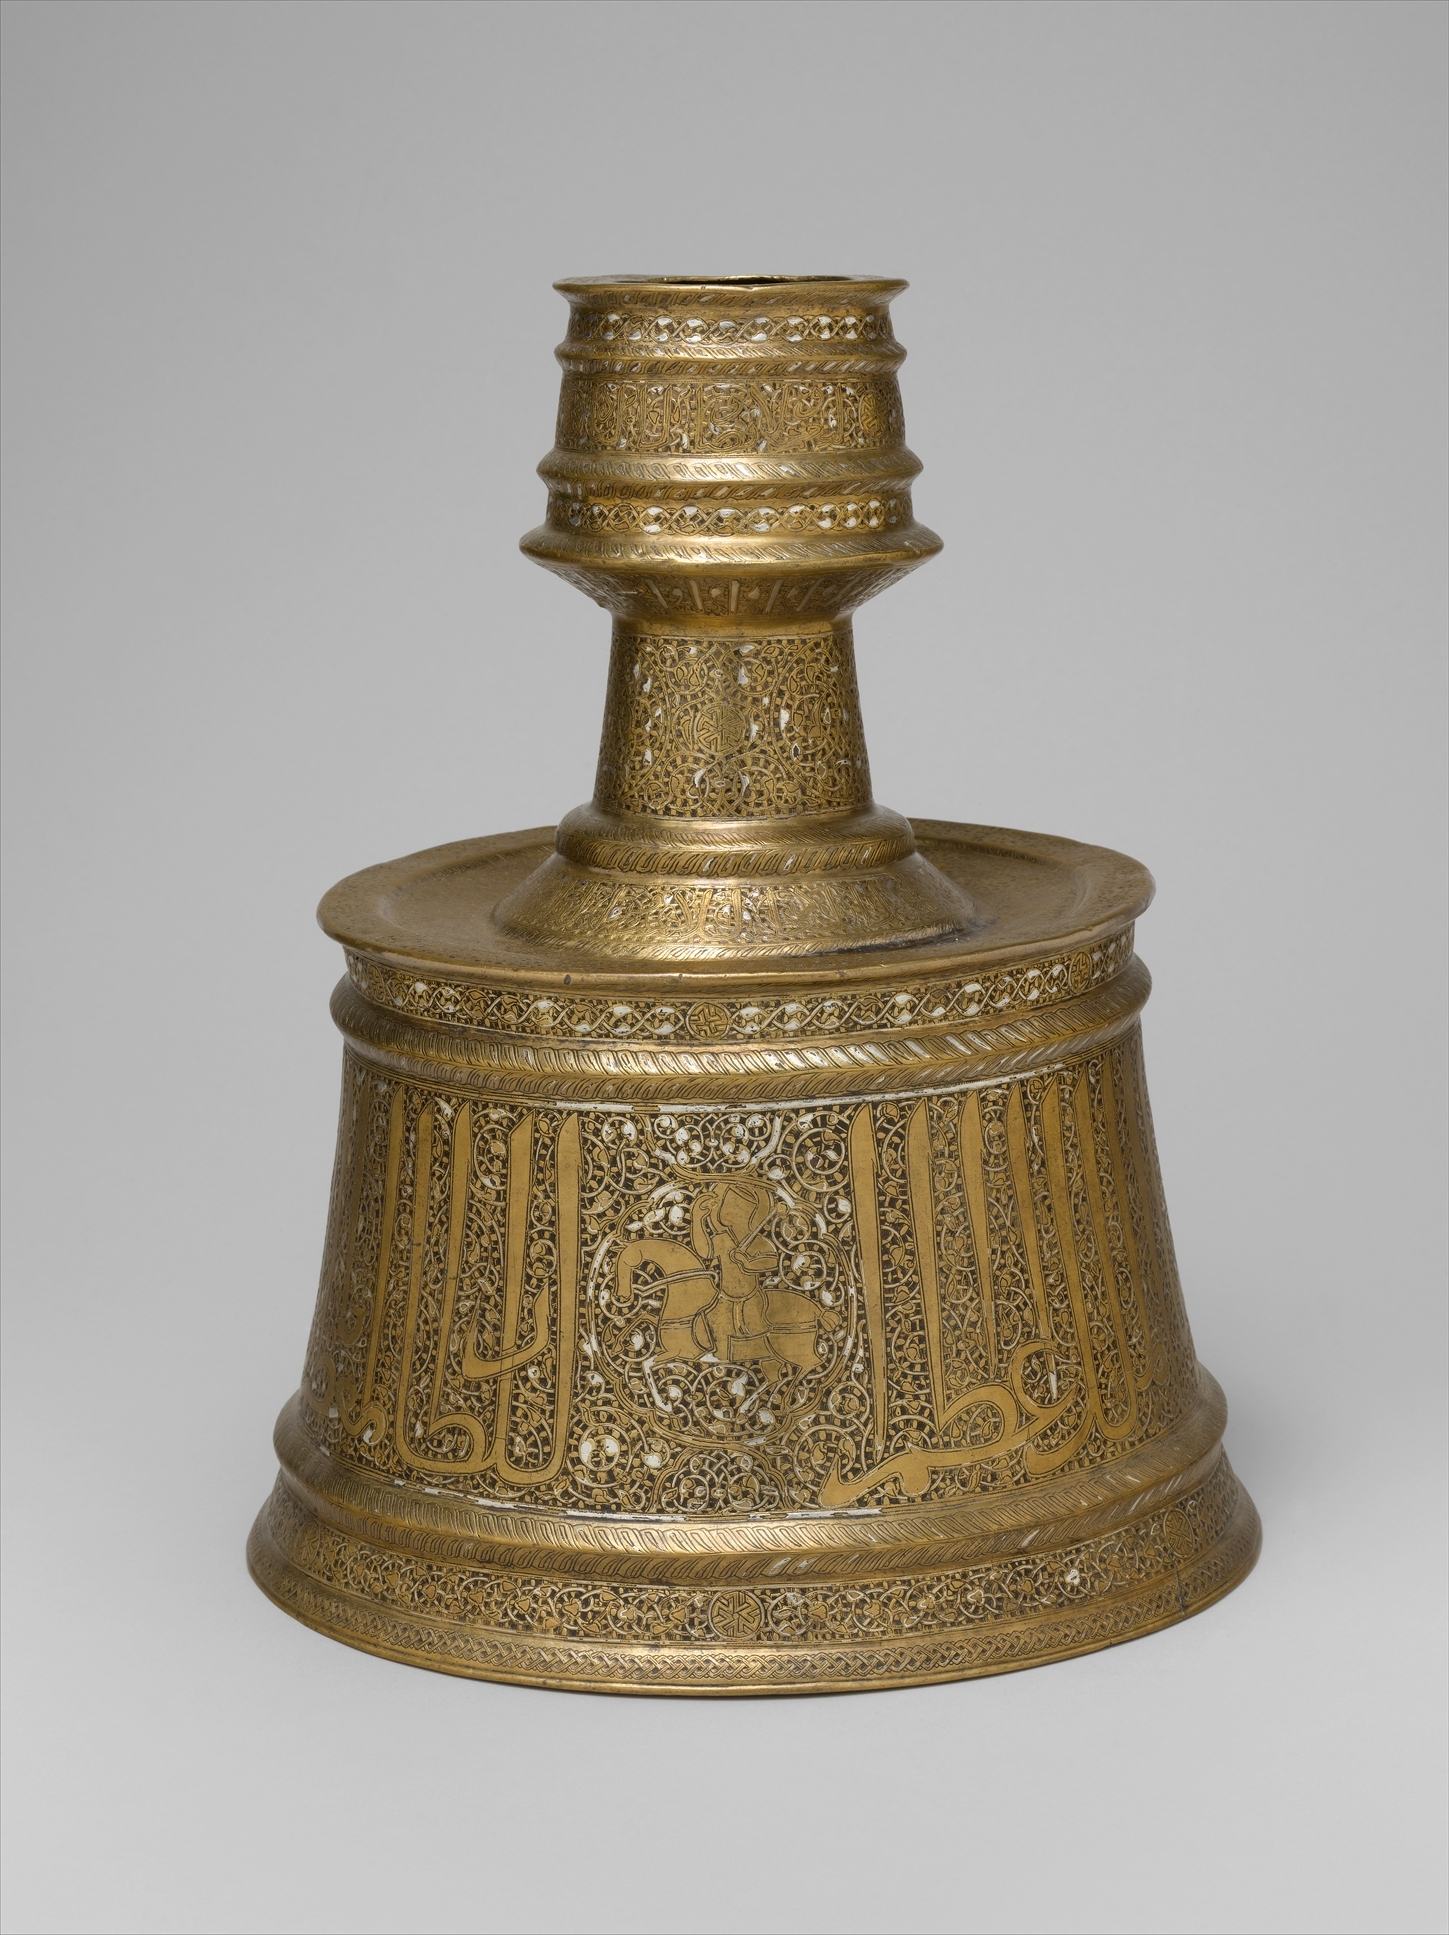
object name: candlestick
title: Candlestick with Horsemen and Arabic Inscriptions Conveying Good Wishes and Blessings Upon the Sultan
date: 1201-1400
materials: brass, silver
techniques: casting, engraving, inlay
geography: iran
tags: arabic,horses